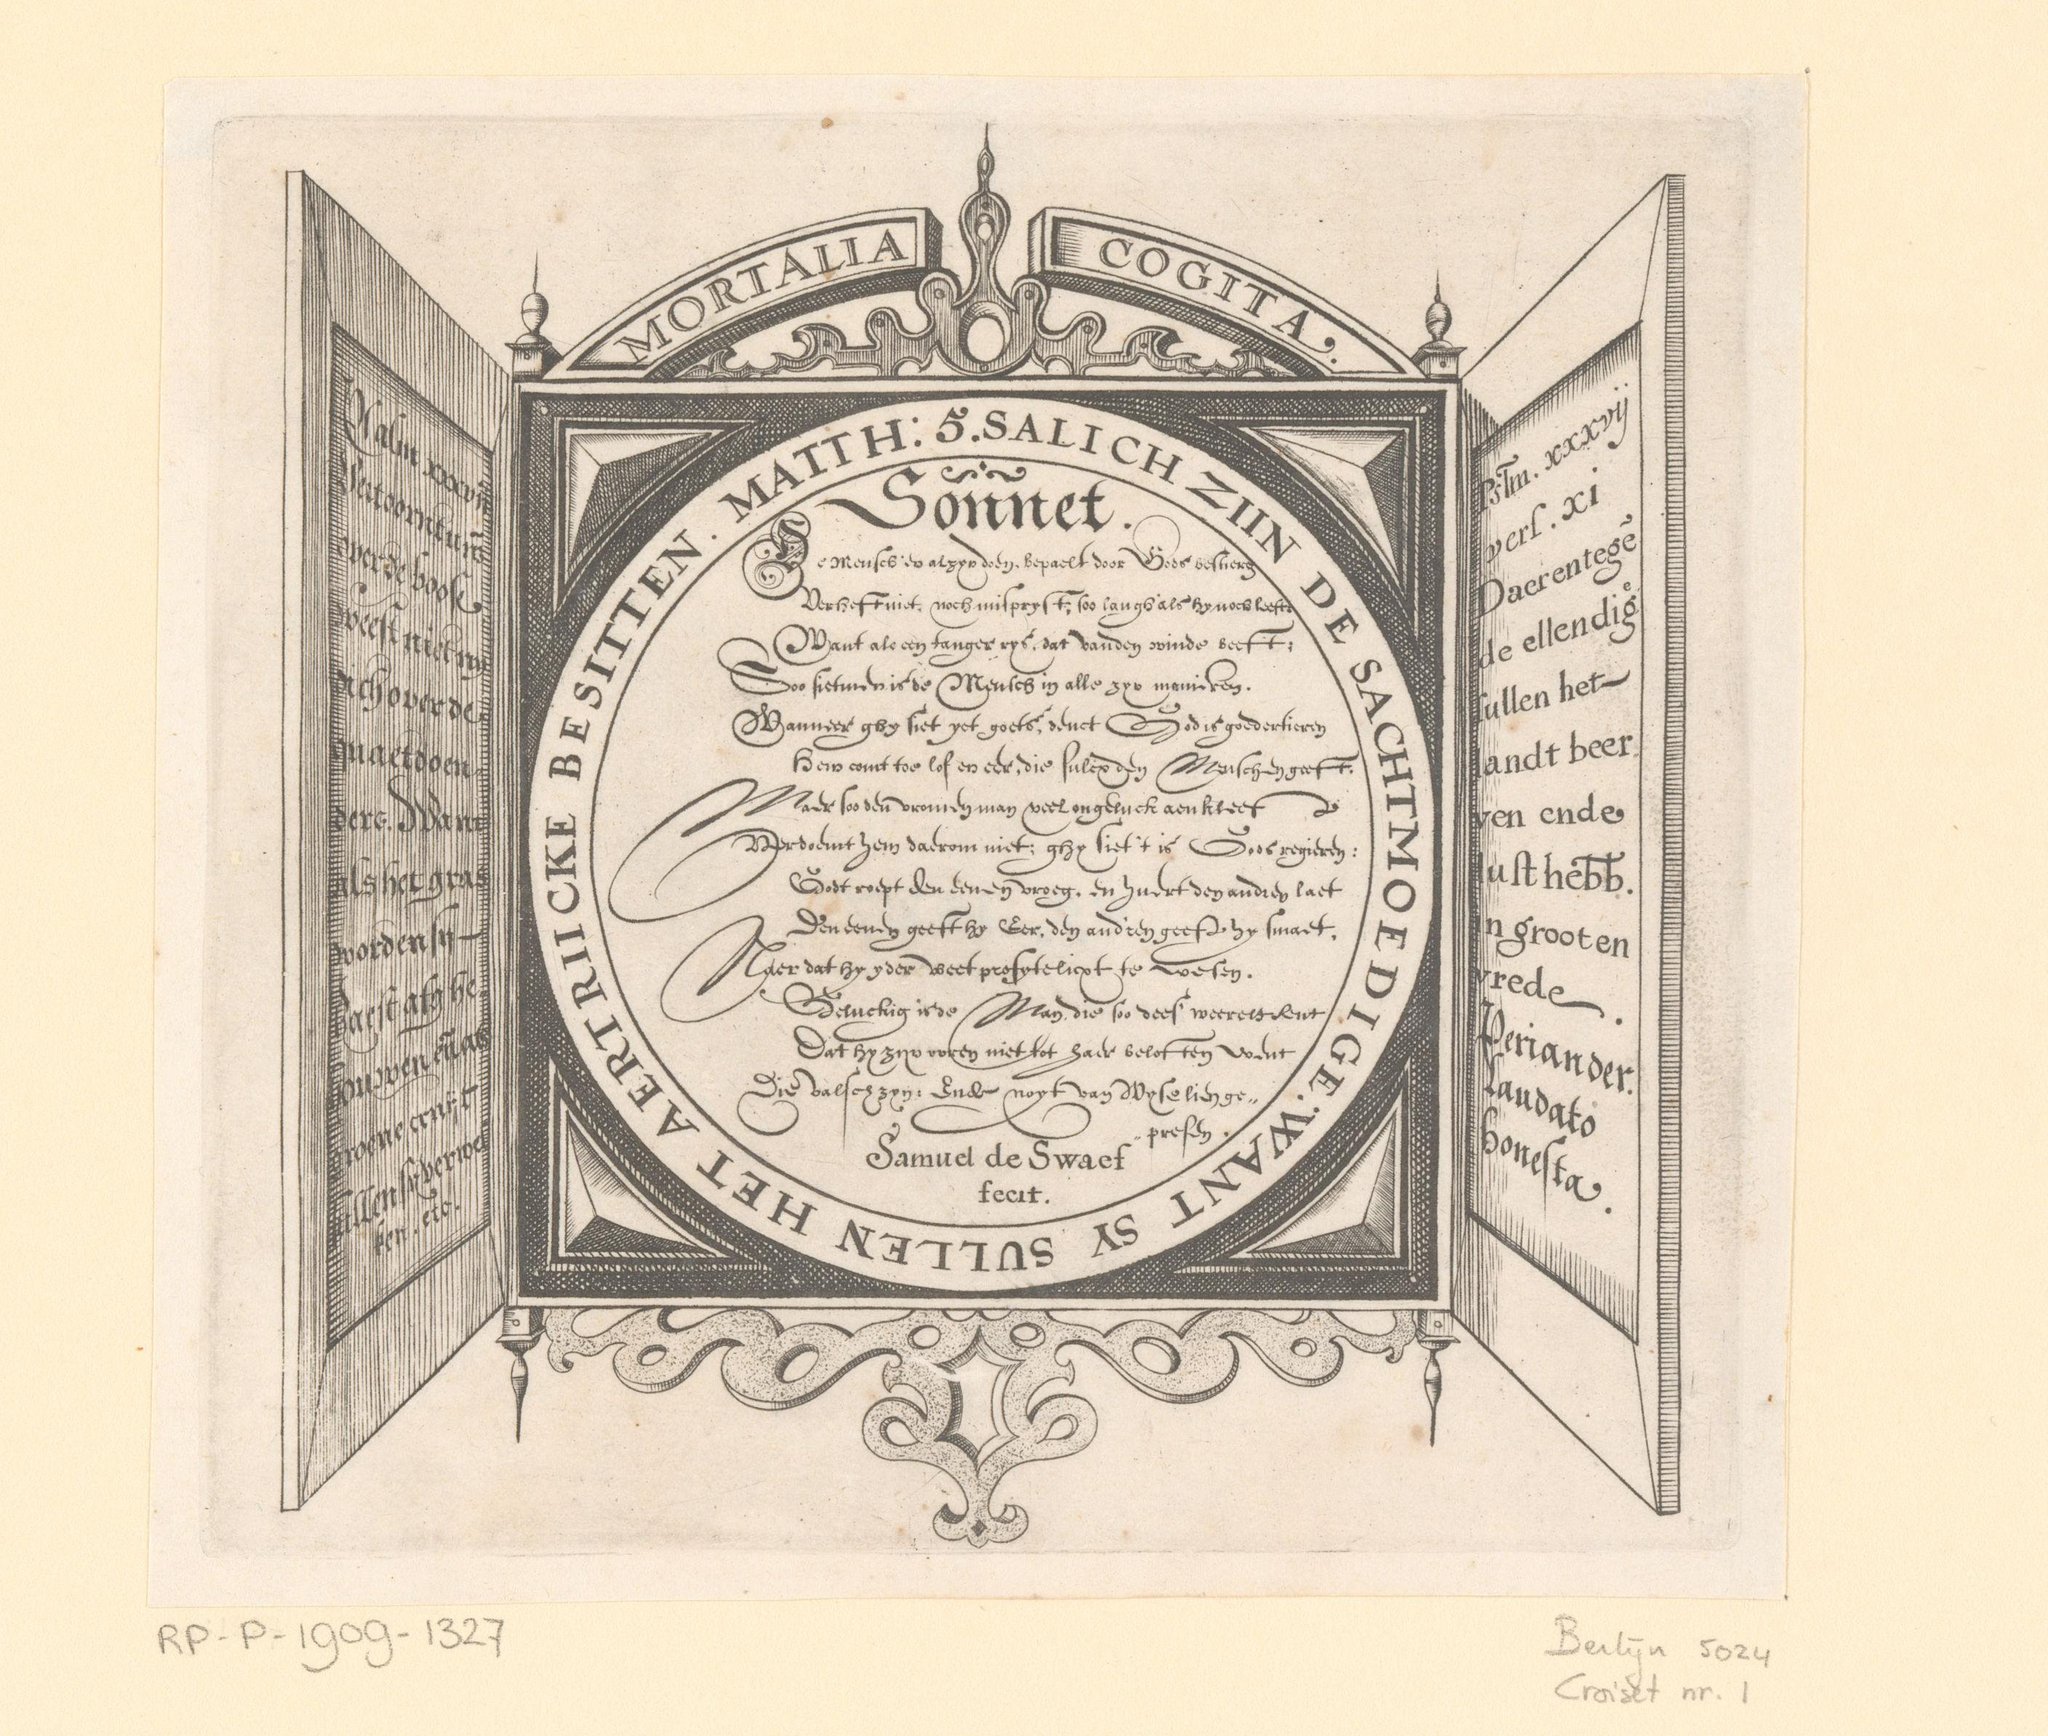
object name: ornament print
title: Sonnet en psalmteksten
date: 1600-1650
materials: paper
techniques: engraving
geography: northern netherlands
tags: calligraphy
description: Drieluik met gekalligrafeerde sonnet en psalmteksten.